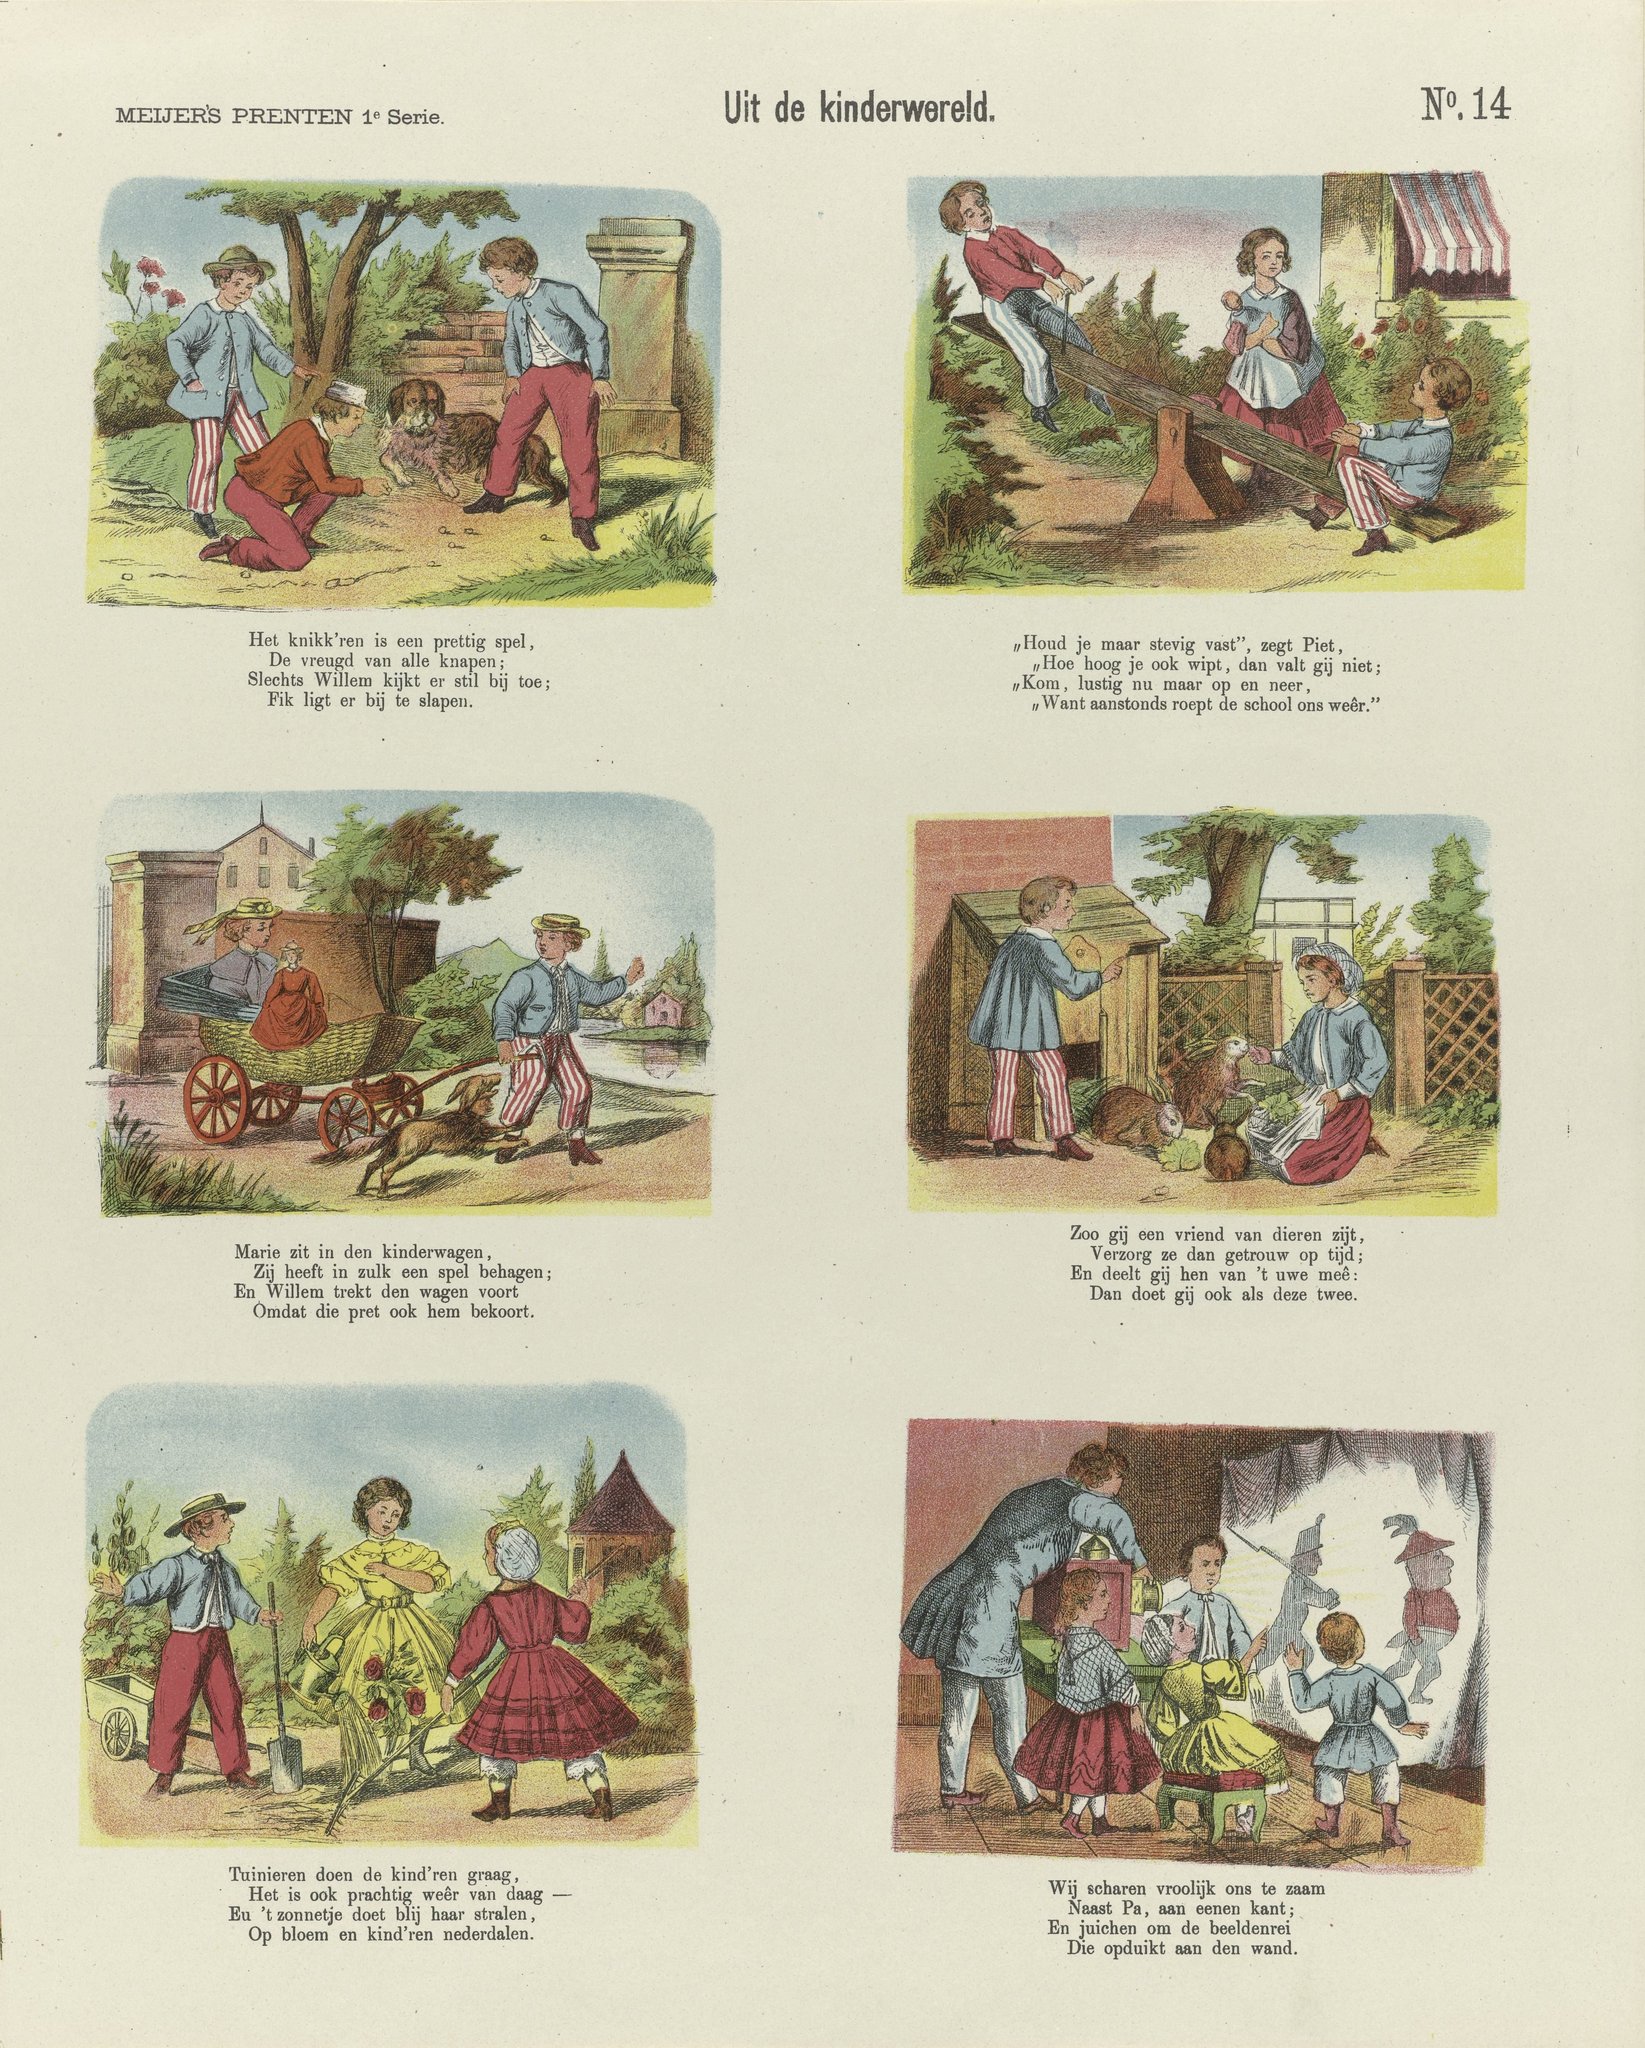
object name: print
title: Meijer's prenten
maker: Anonymous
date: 1873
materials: paper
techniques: lithograph, letterpress printing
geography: amsterdam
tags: children's games and plays, gardening, child playing with animals, seesaw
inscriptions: collector's mark: Lugt 2760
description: Blad met 6 voorstellingen van kinderspelen en bezigheden, waaronder knikkeren, wippen, rijden in een wagen, konijnen voeren en tuinieren. Onder elke afbeelding een vierregelig vers. Genummerd rechtsboven: No. 14.